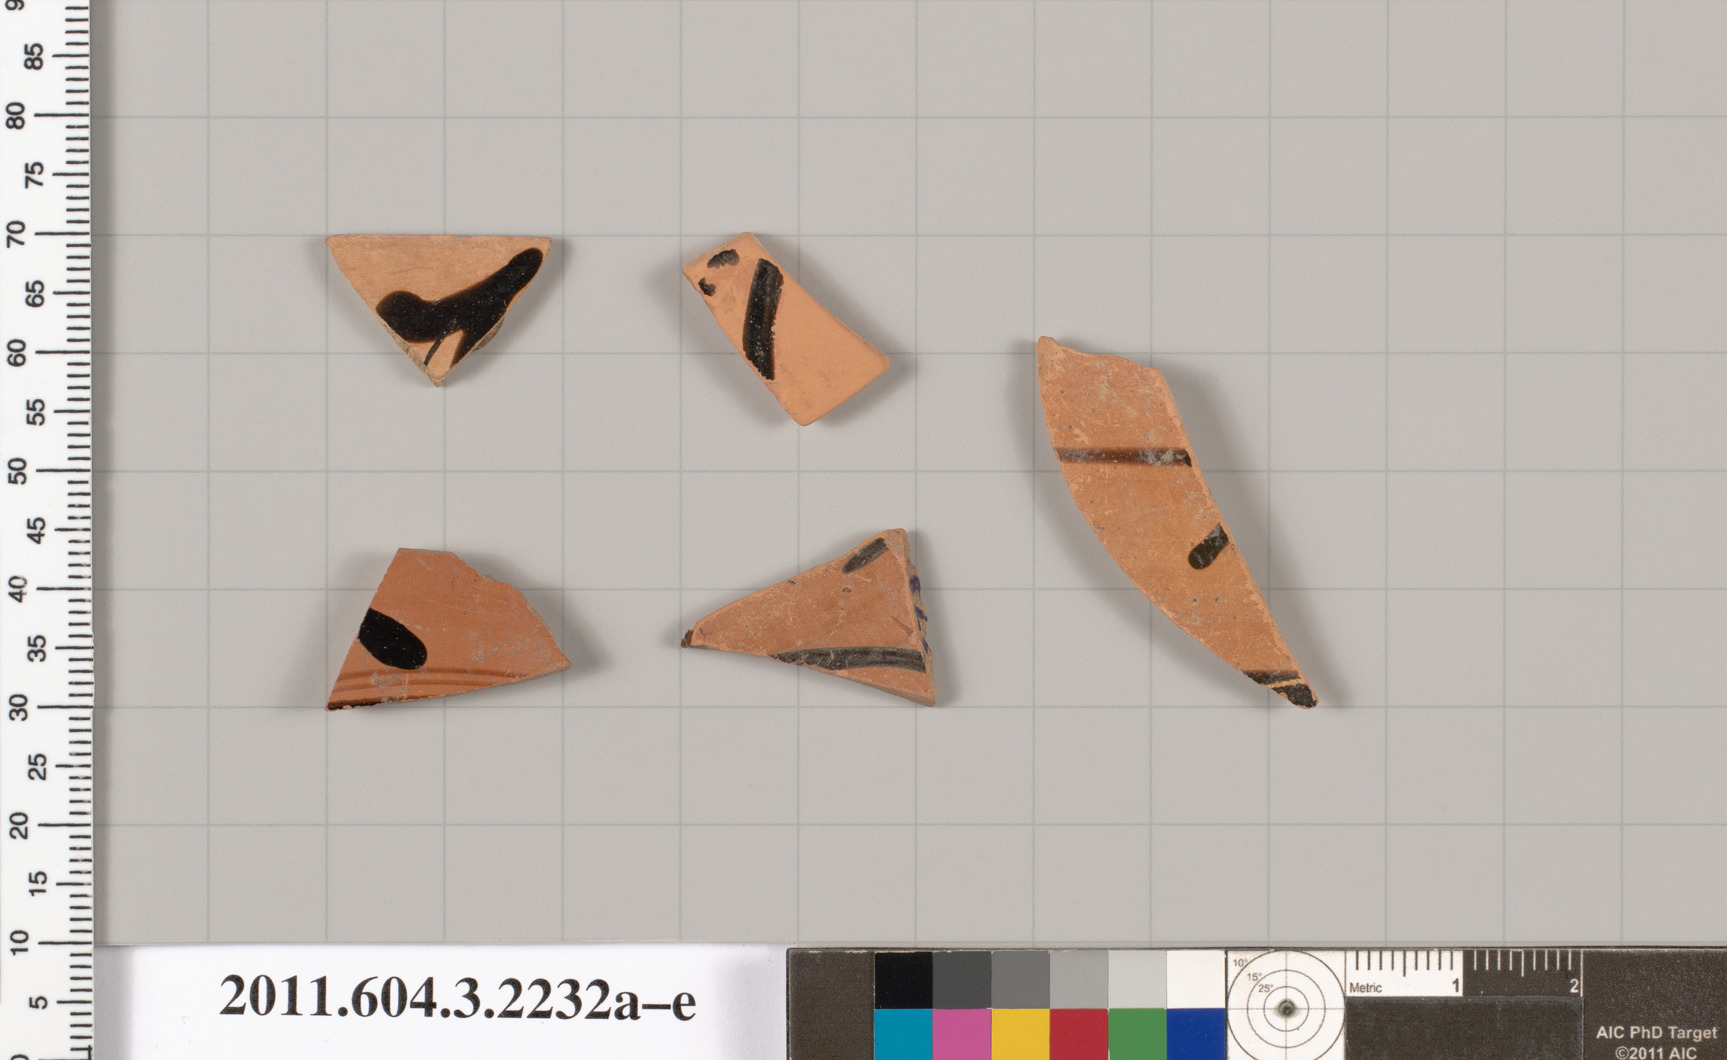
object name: kylix fragment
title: Terracotta fragments of kylikes (drinking cups)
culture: greek, attic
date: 600-401 BCE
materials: terracotta